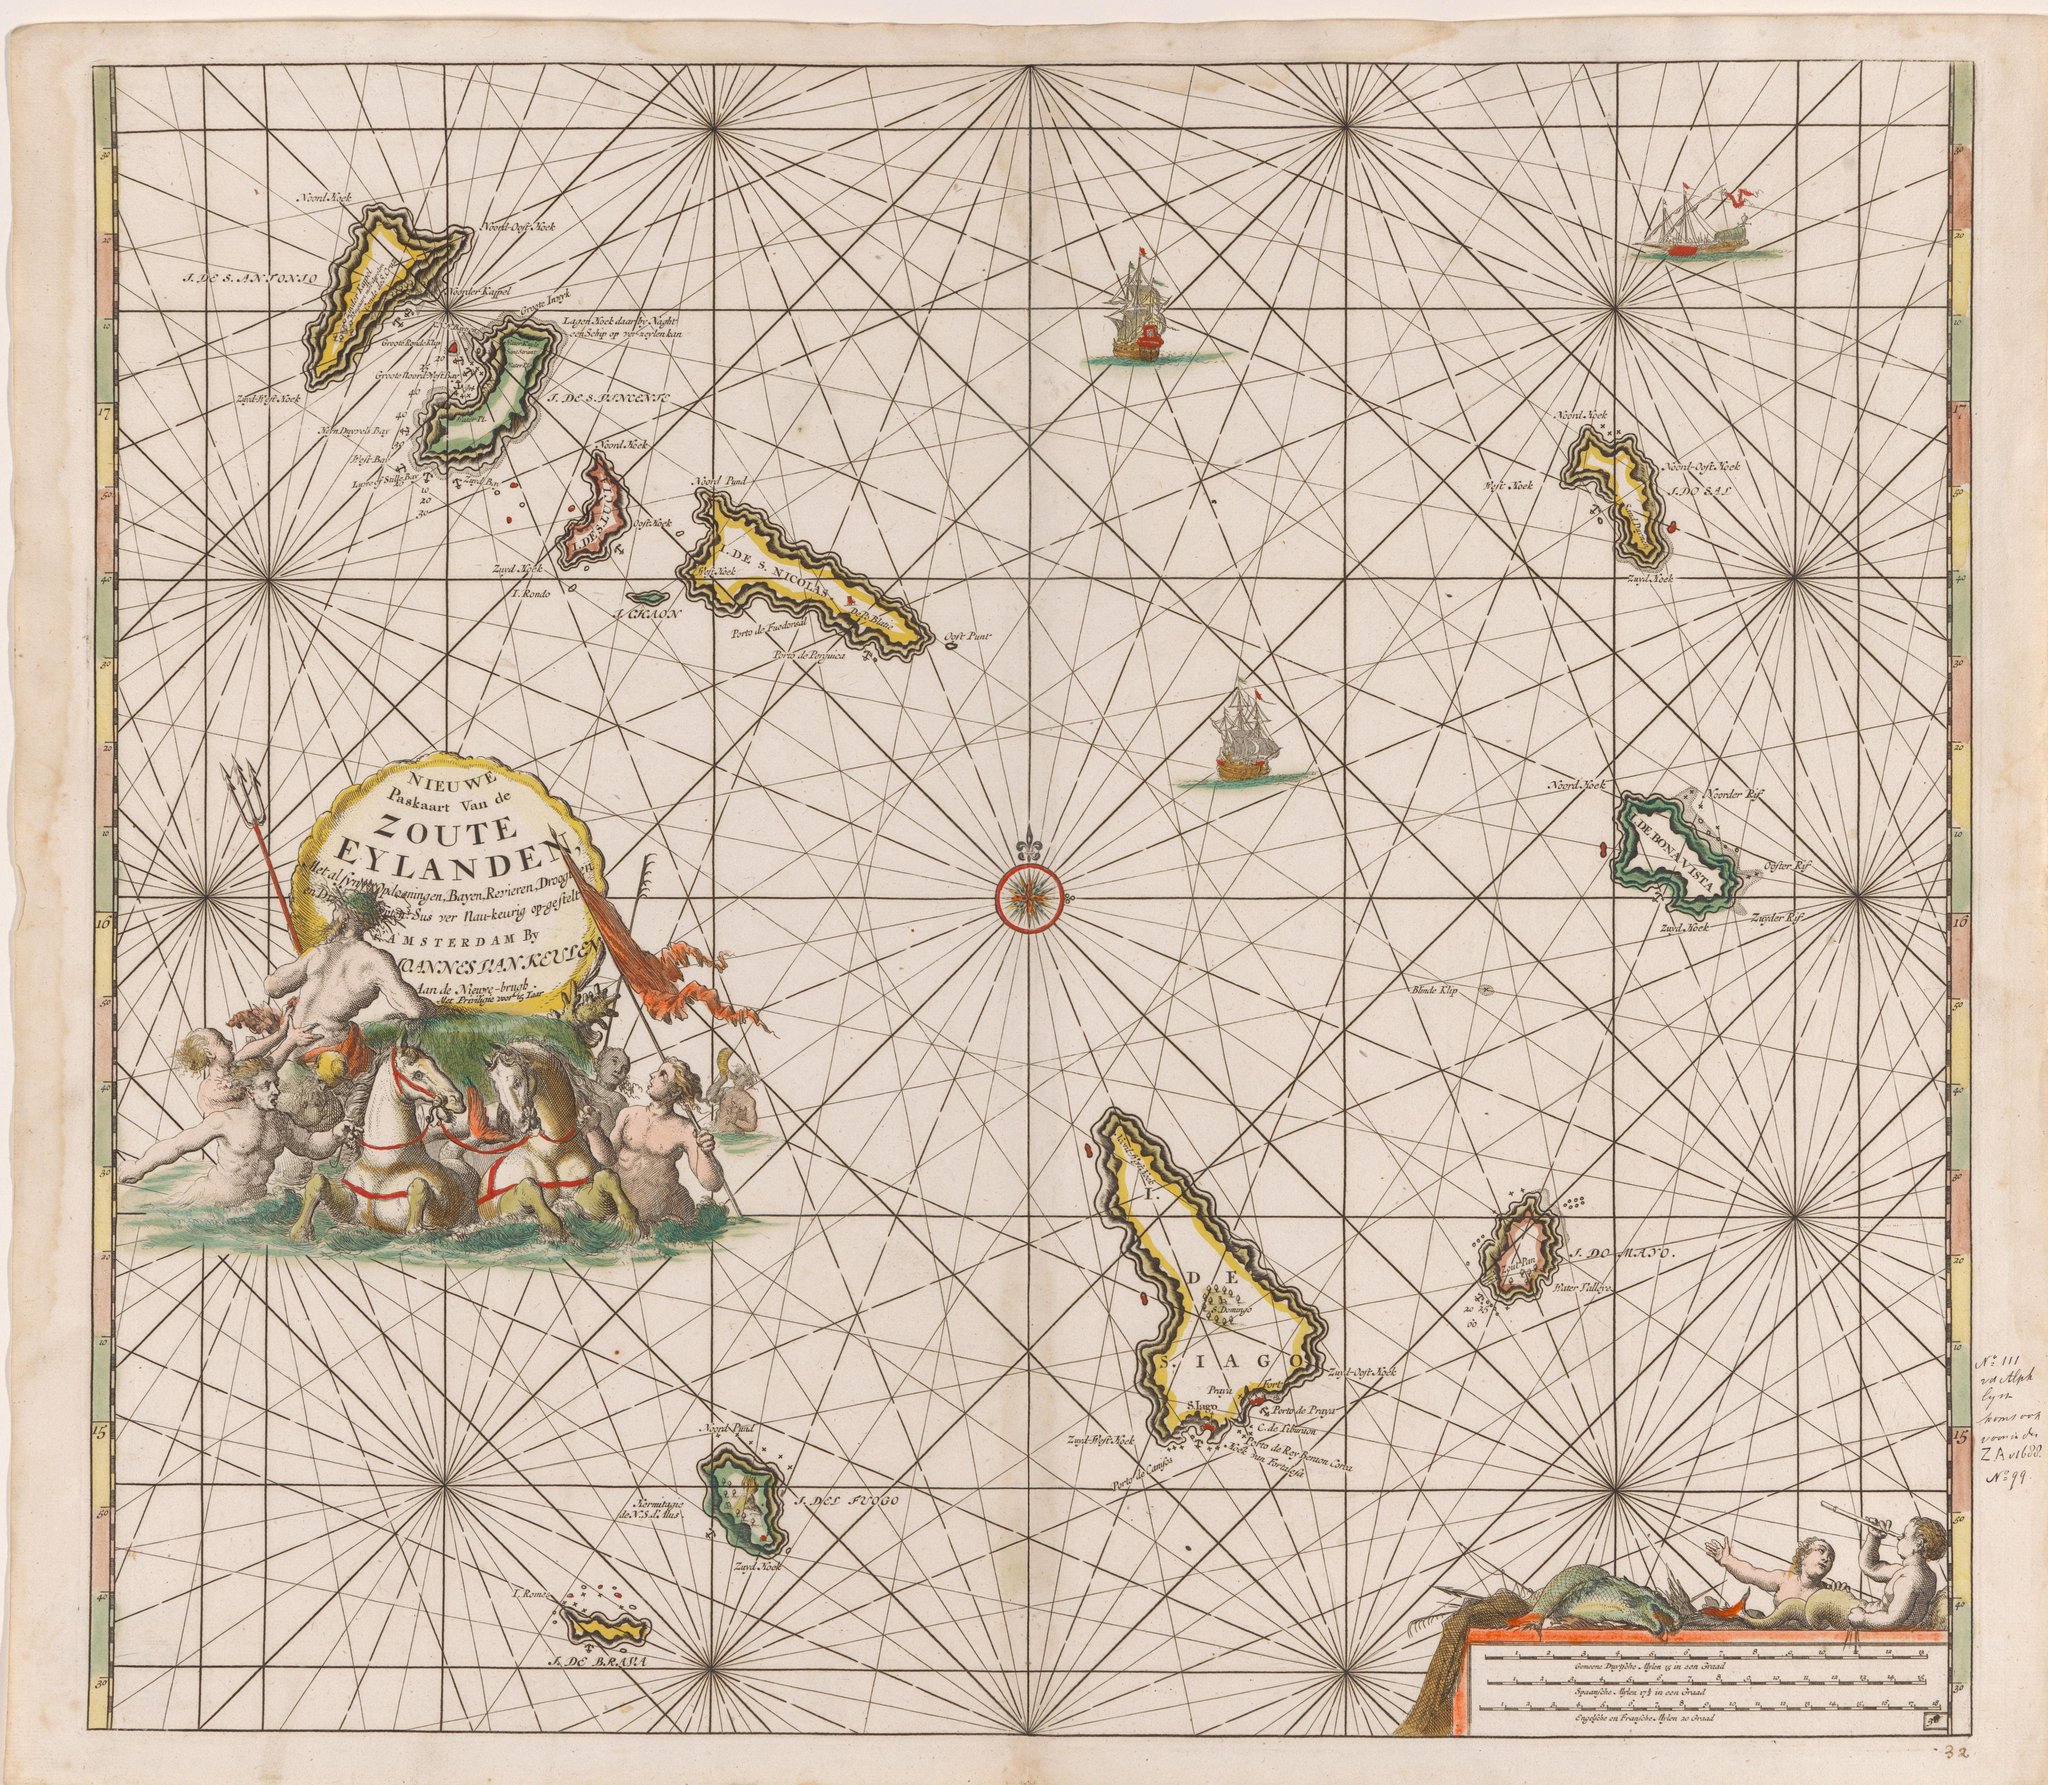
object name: print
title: Paskaart van de Kaapverdische eilanden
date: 1680-1684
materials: paper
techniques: brush, etching, hand coloring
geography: amsterdam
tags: (story of) neptune (poseidon), sailing-ship, sailing-boat, maps, atlases, cupids: 'amores', 'amoretti', 'putti', binoculars, spy-glass, etc.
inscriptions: collector's mark: Lugt 2228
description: Paskaart van de Kaapverdische eilanden met een kompasroos, het Noorden ligt boven. Links een vignet met Neptunes die zijn schelpenwagen bestijgt, waarop de titel, en wordt vergezeld door diverse zeewezens. Rechtsonder de schaal in Duitse, Spaanse en Engelse of Franse mijlen.